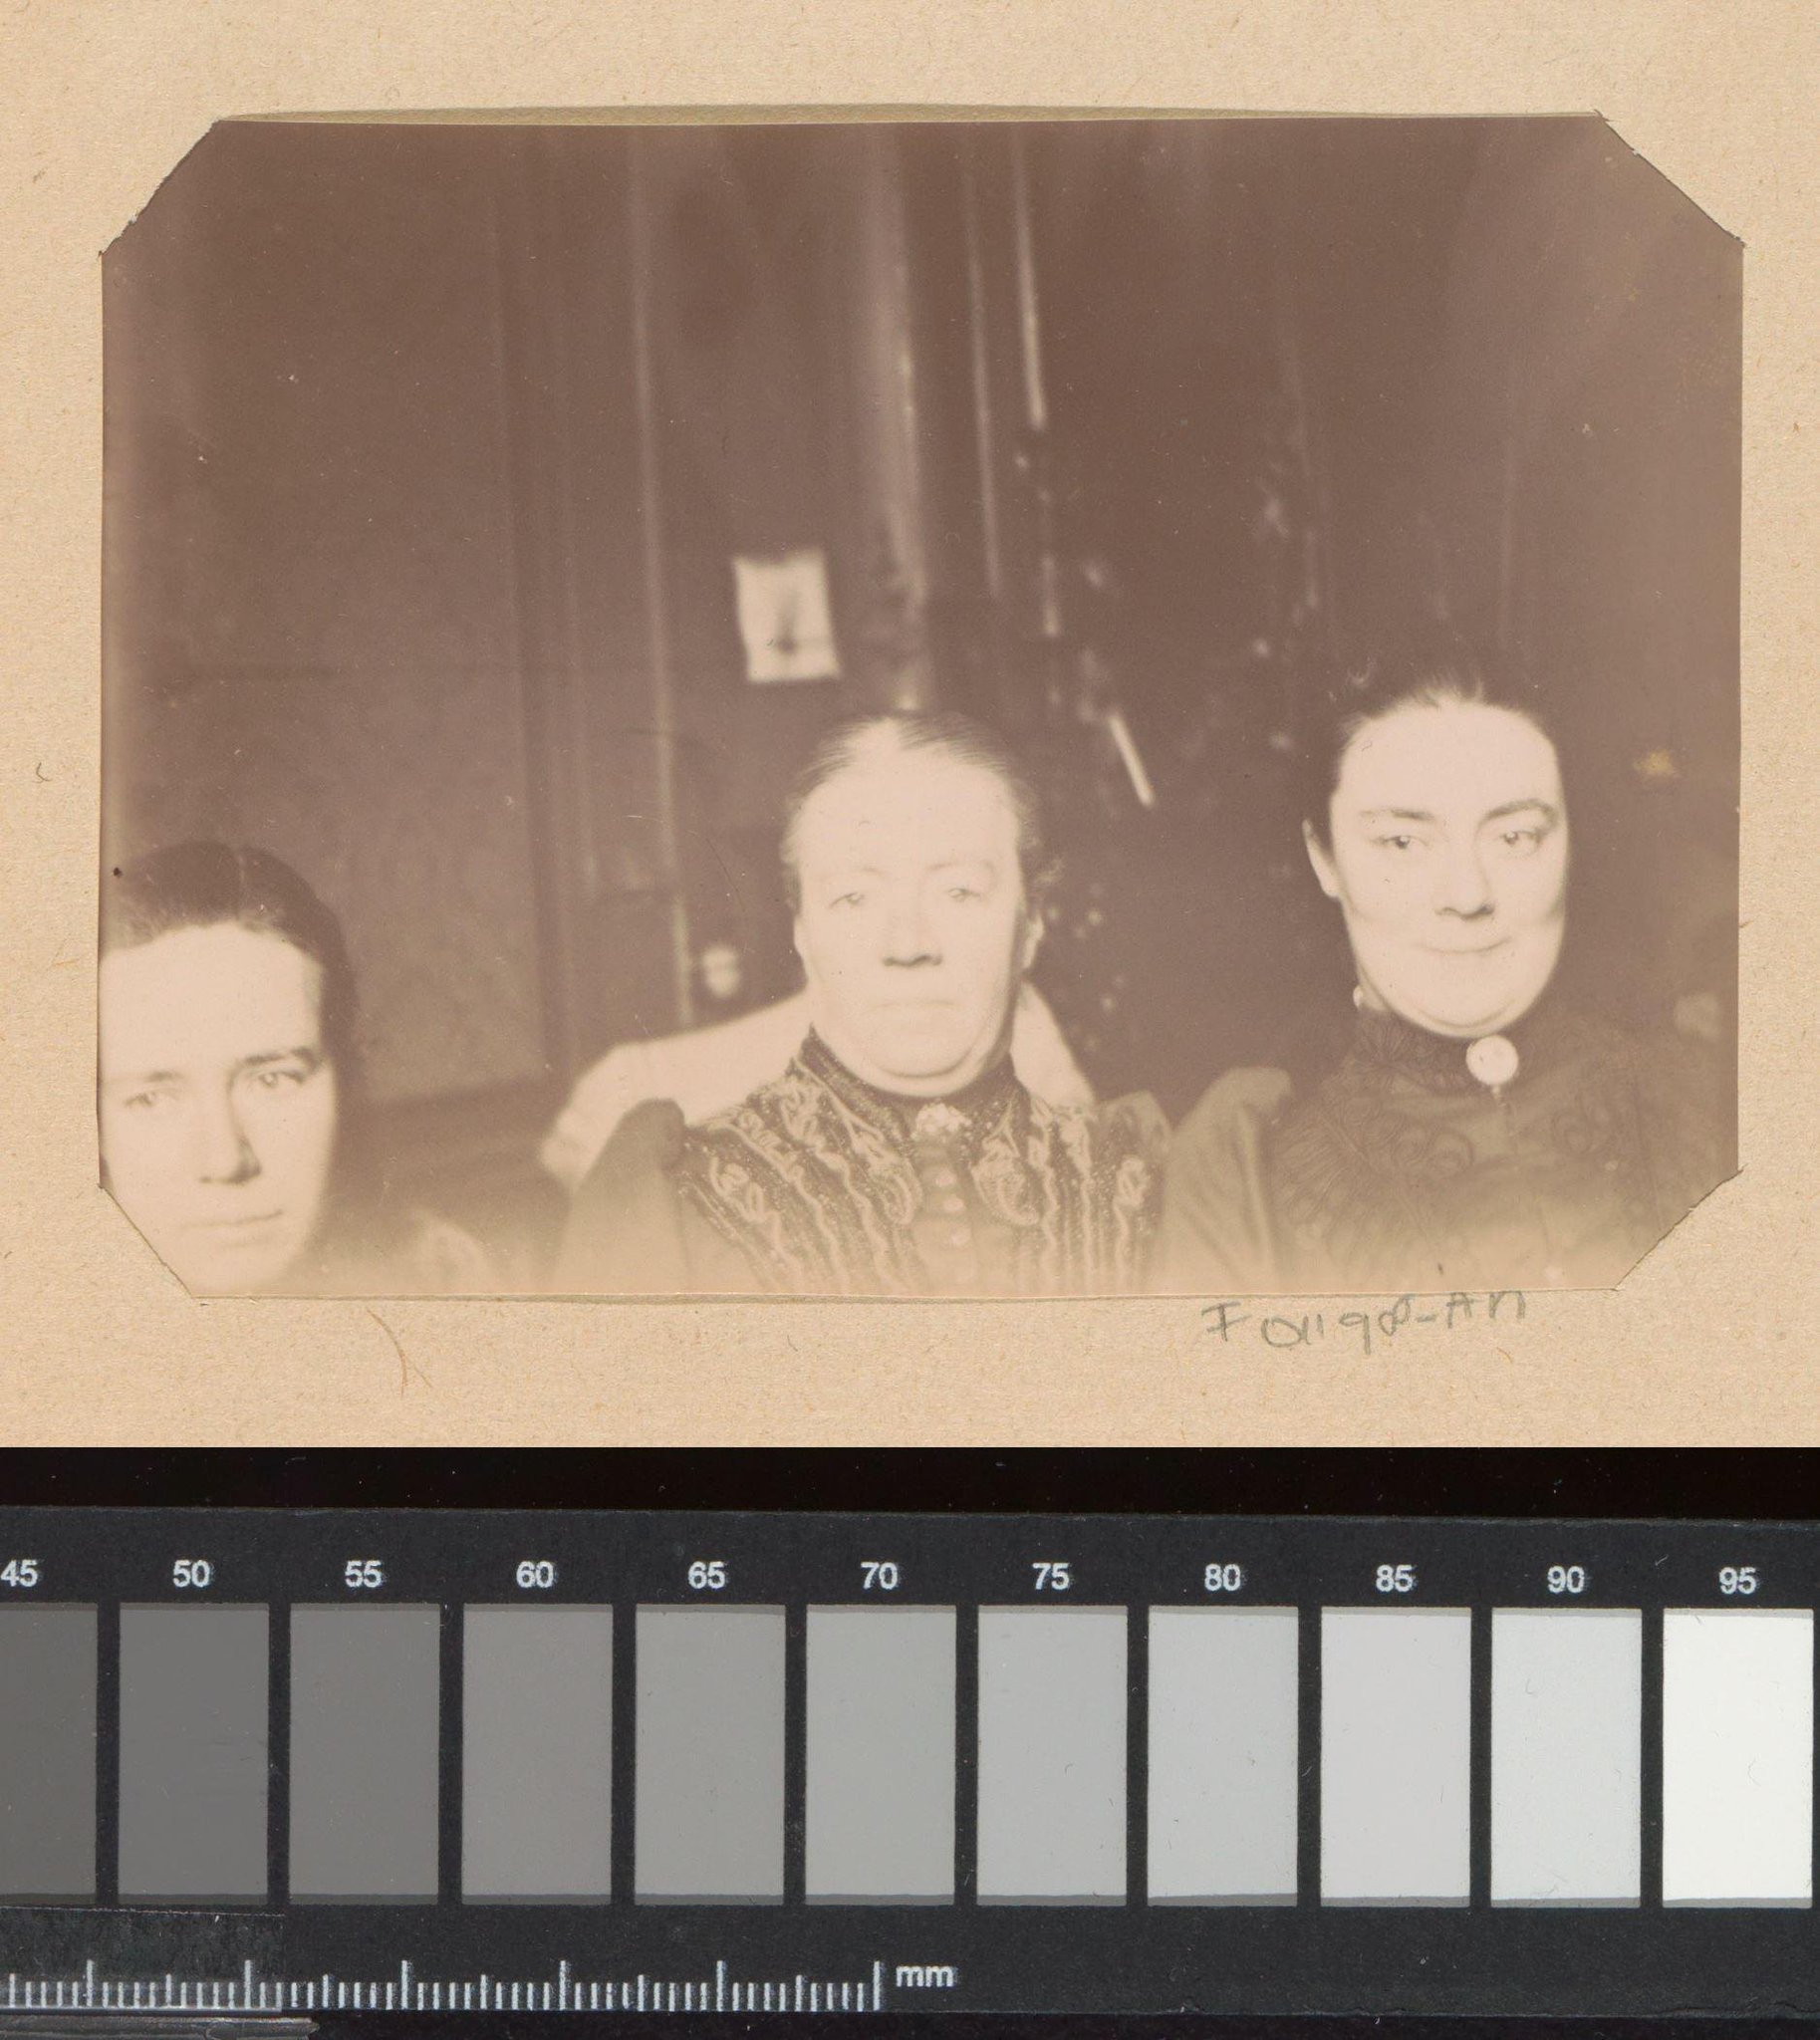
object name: photograph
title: Drie vrouwen in een huiselijk interieur, Gesiena, Lucia en Cato Piek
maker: johanna margaretha piek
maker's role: fotograaf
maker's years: 1870-1947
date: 1889-1893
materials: paper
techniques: gelatin silver print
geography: netherlands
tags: amsterdam, adult woman, netherlands